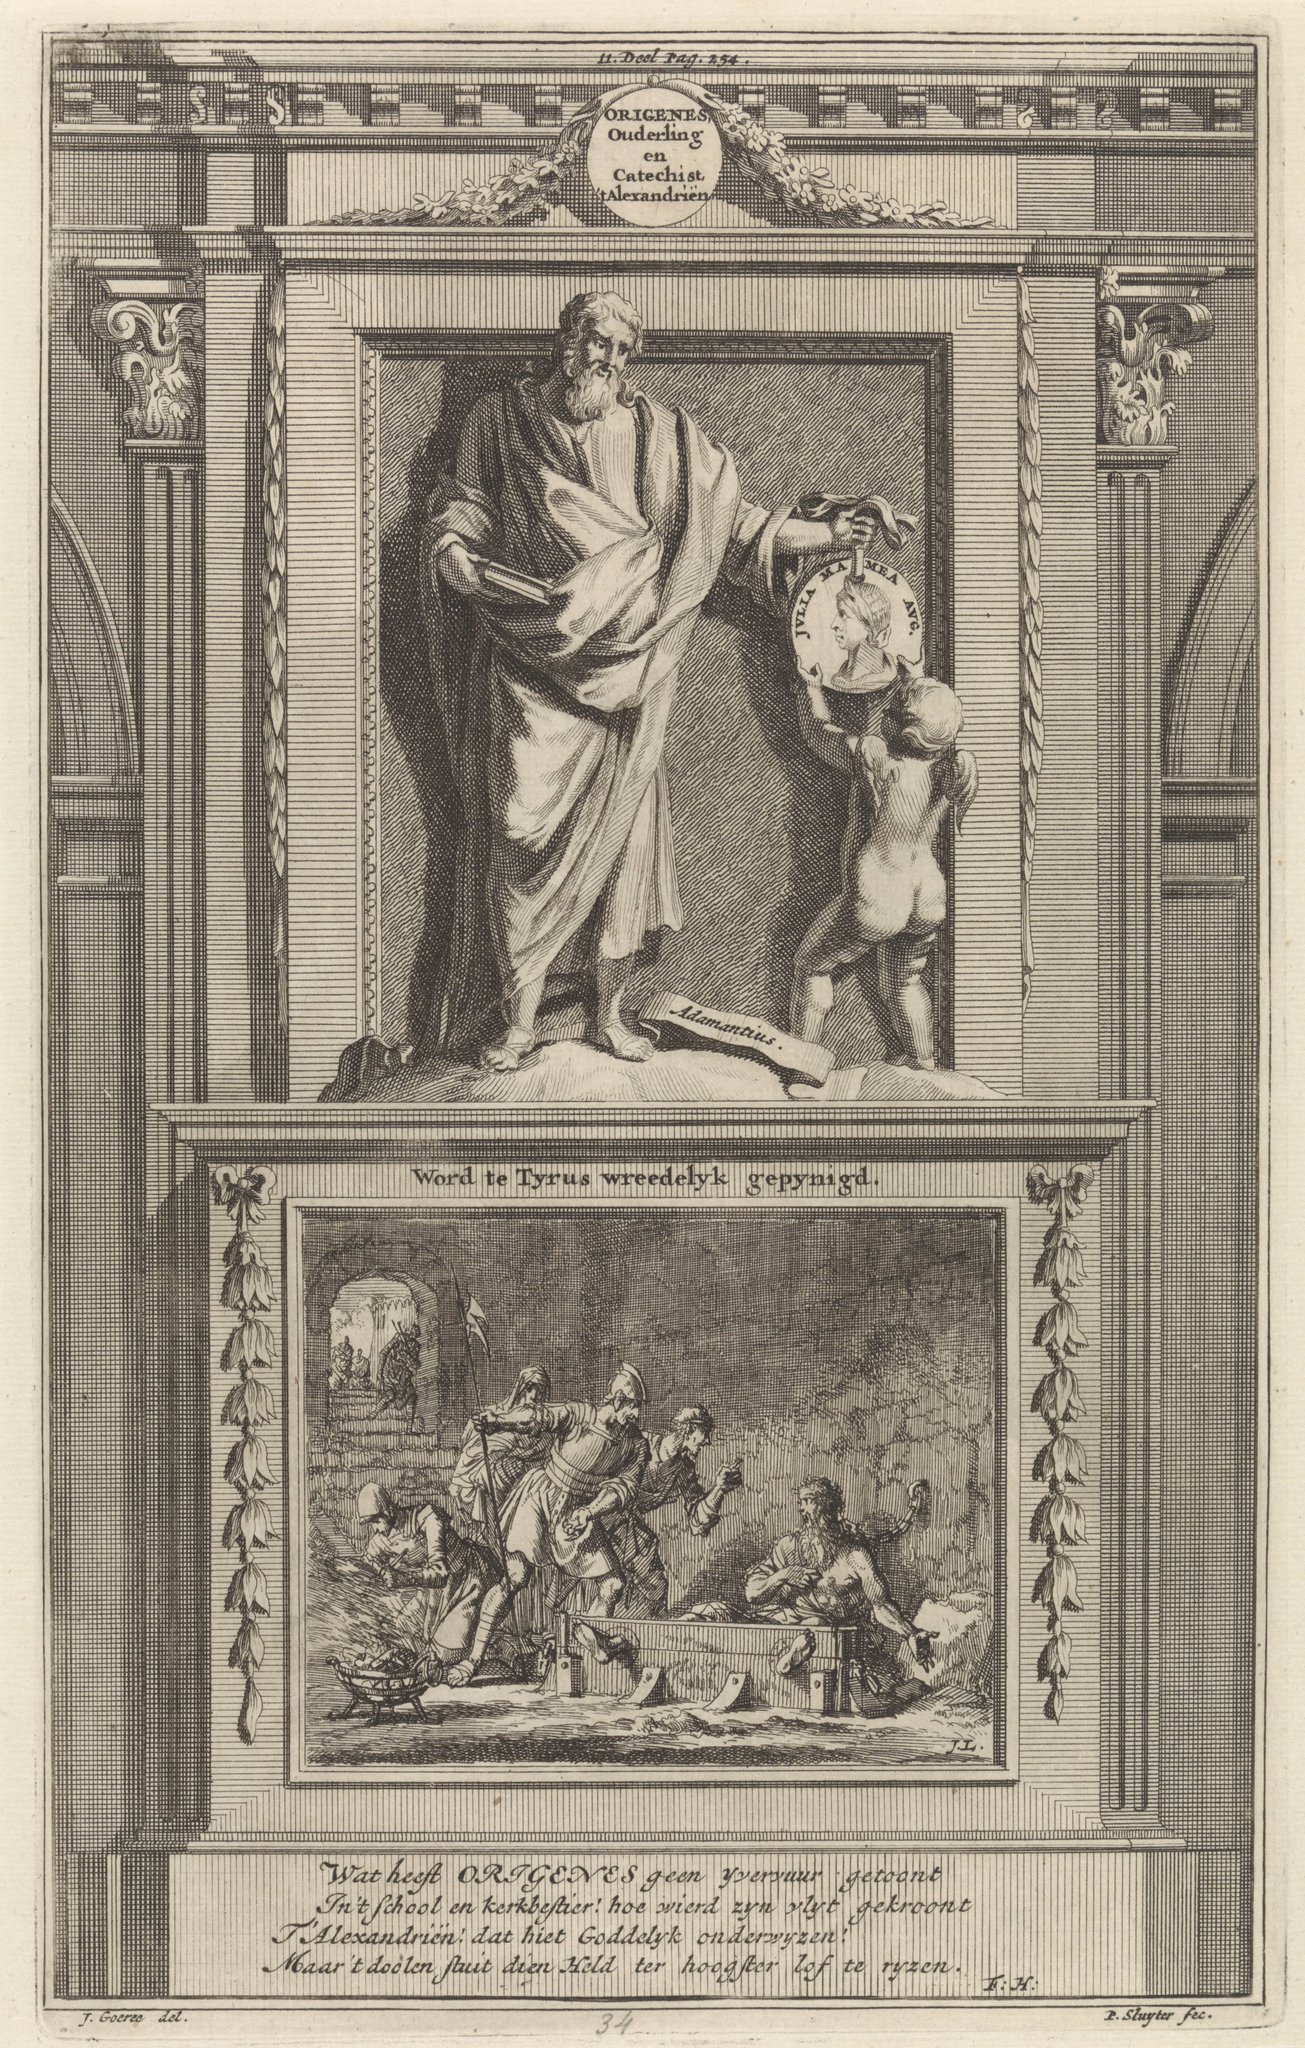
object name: print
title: Kerkvader Origenes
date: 1698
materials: paper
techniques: engraving, etching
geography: amsterdam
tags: prison, jail, instruments of torture, execution or punishment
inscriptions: collector's mark: Lugt 2228, number: ‘34’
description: De kerkvader Origenes toont een engel een portretmedaillon. Origenes staat op een sokkel waar op de voorzijde zijn marteldood in beeld is gebracht. Prent middenboven gemerkt: II. Deel Pag. 254.